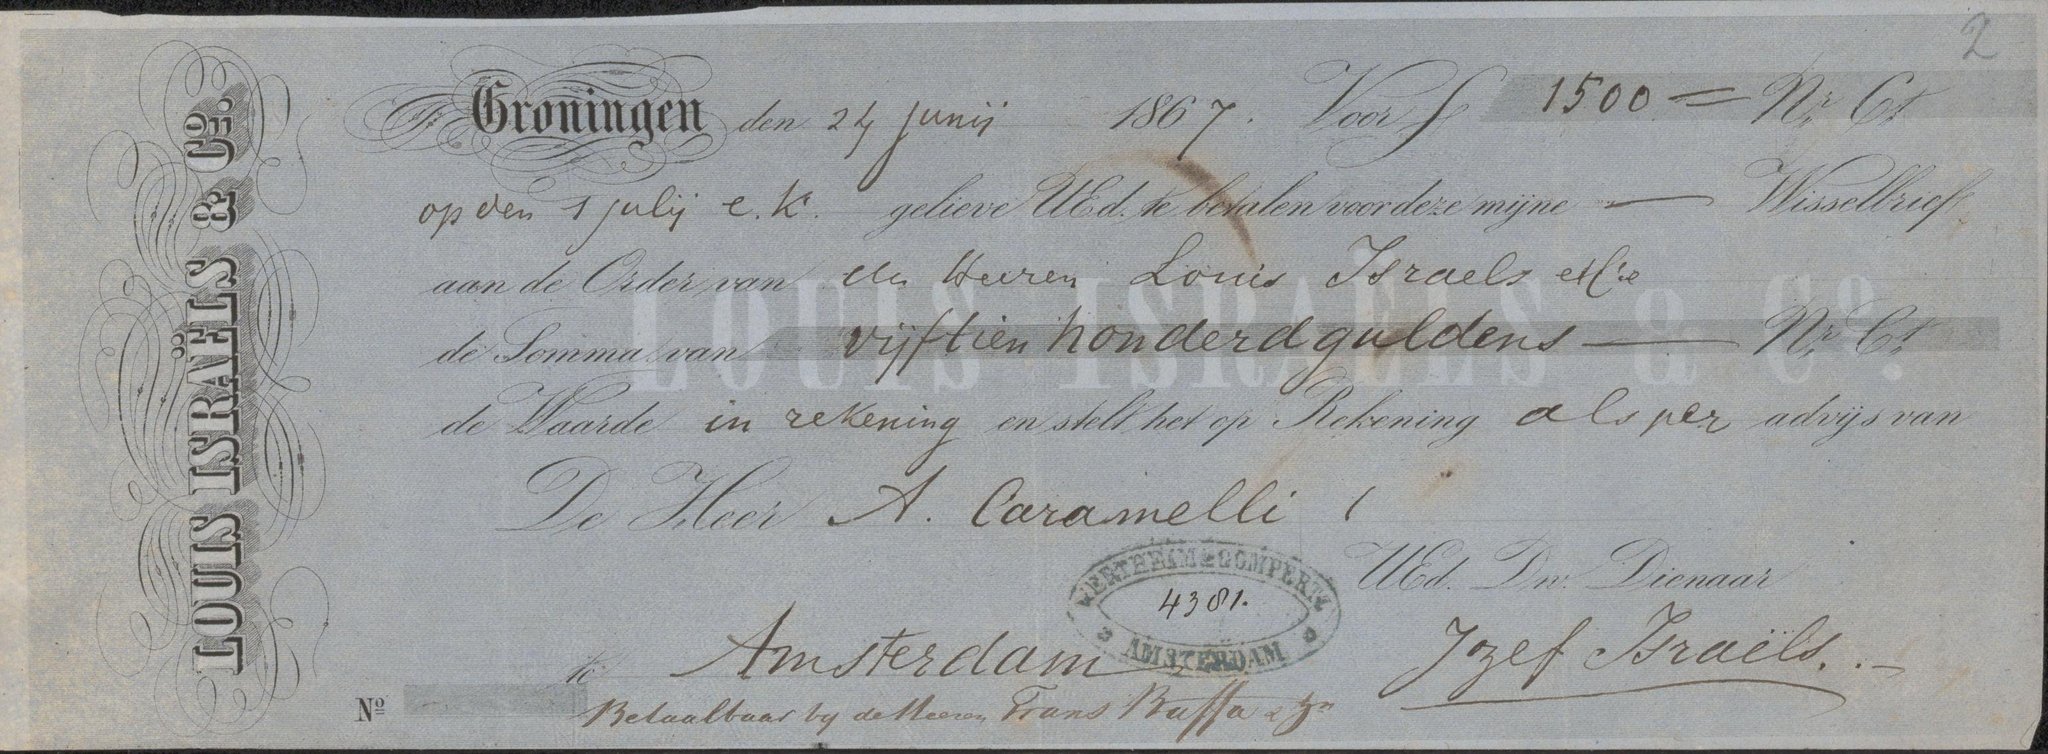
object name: letter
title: Wisselbrief voor Alberto Caramelli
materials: ink, paper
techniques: pen, printing, writing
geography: the hague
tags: utrecht, alberto caramelli, money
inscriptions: collector's mark: Lugt 2233